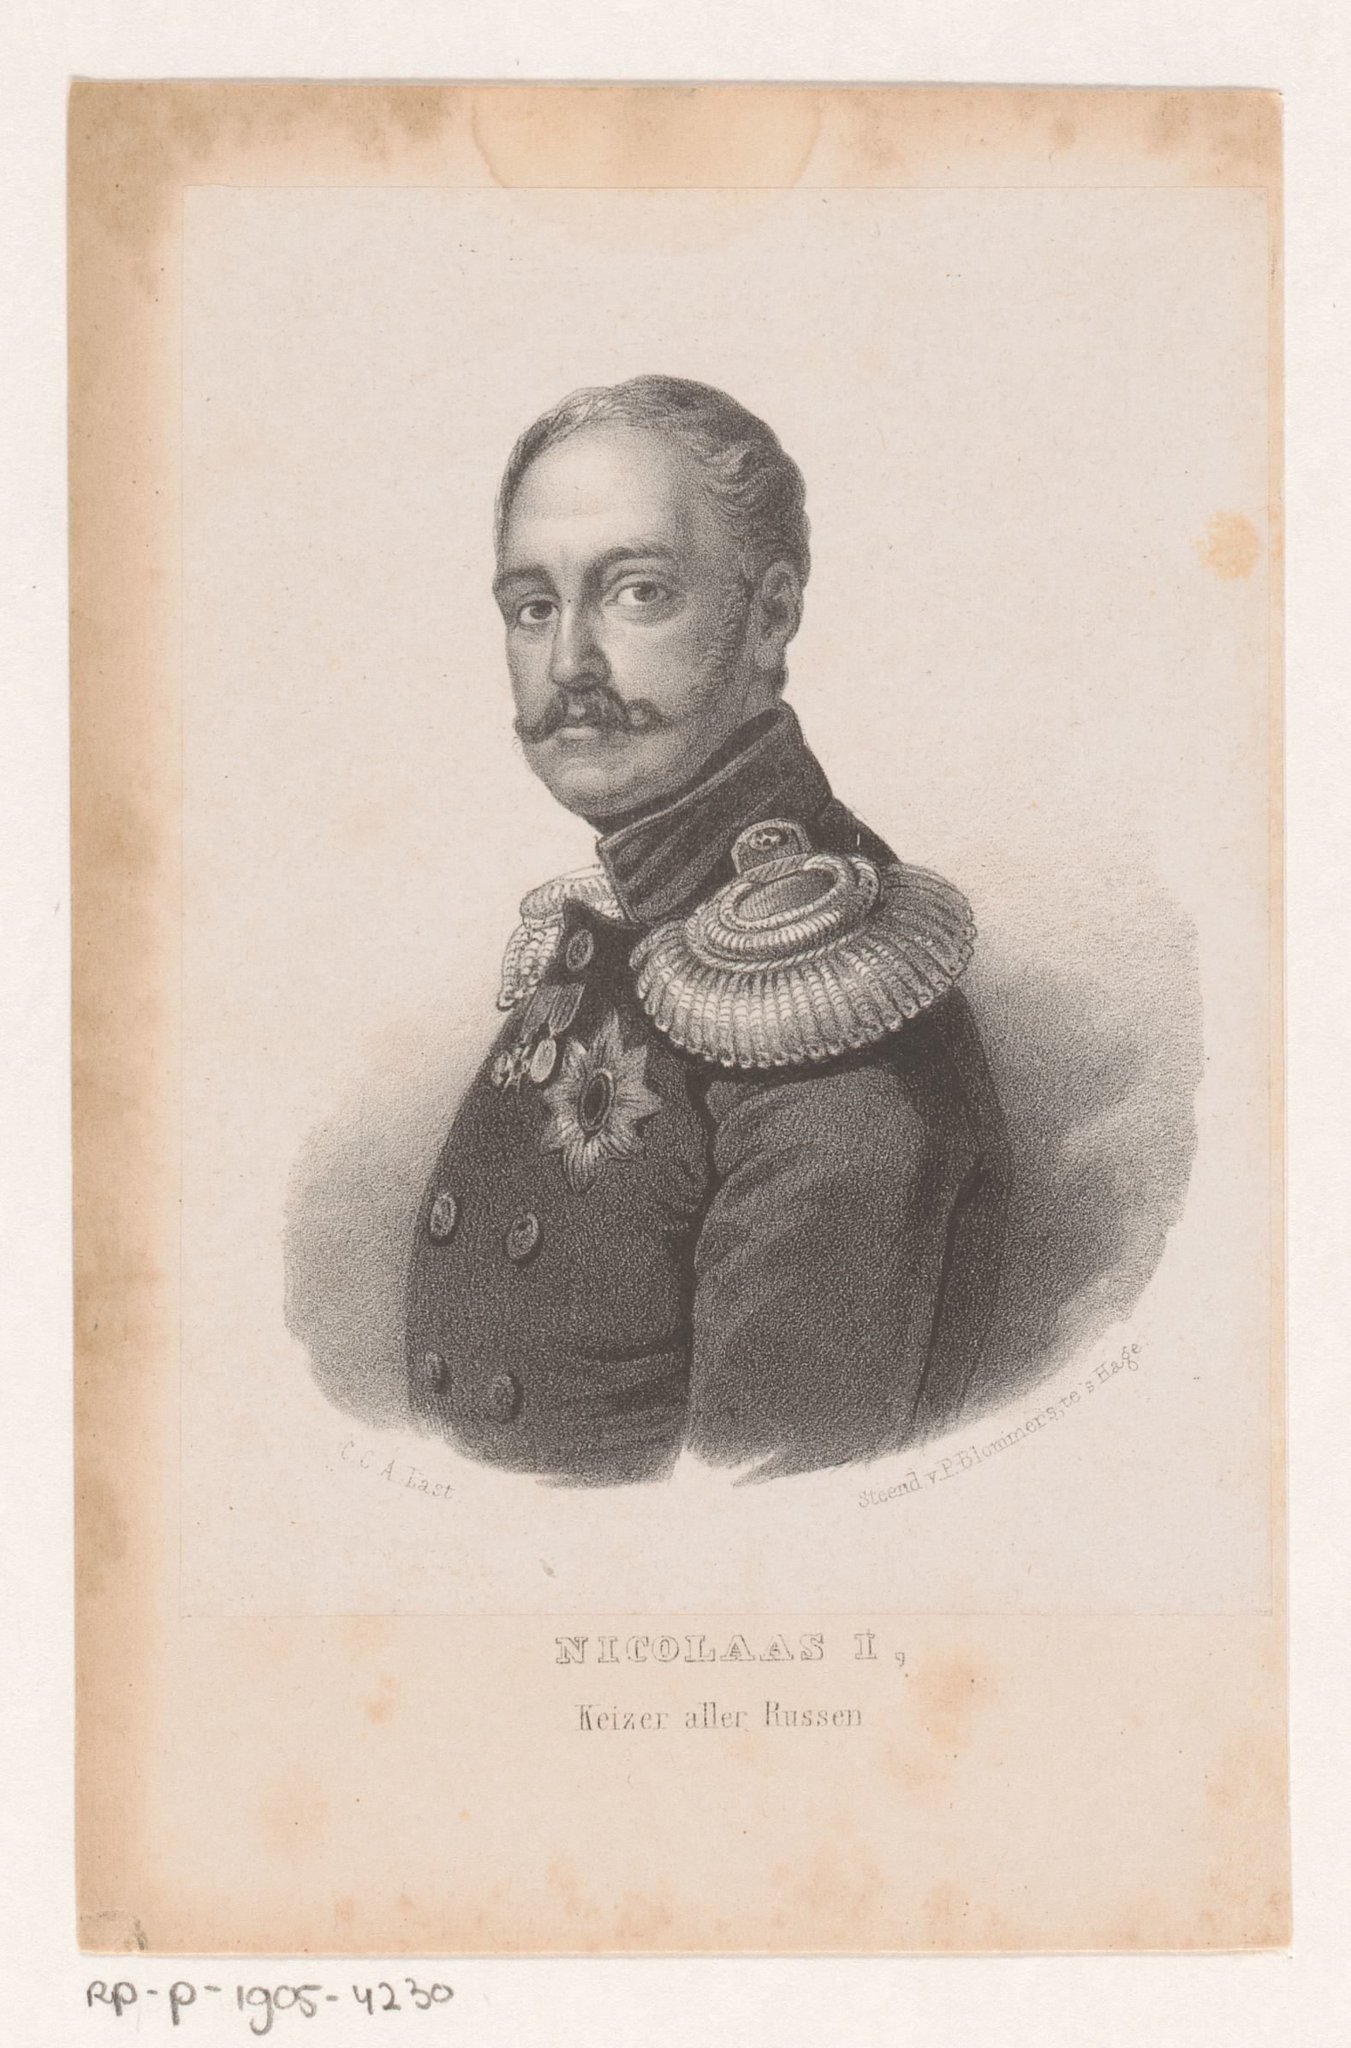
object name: print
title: Portret van Nicolaas I van Rusland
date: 1842-1887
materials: paper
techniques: lithograph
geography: netherlands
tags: historical persons (+ (full) bust portrait)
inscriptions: collector's mark: Lugt 2228